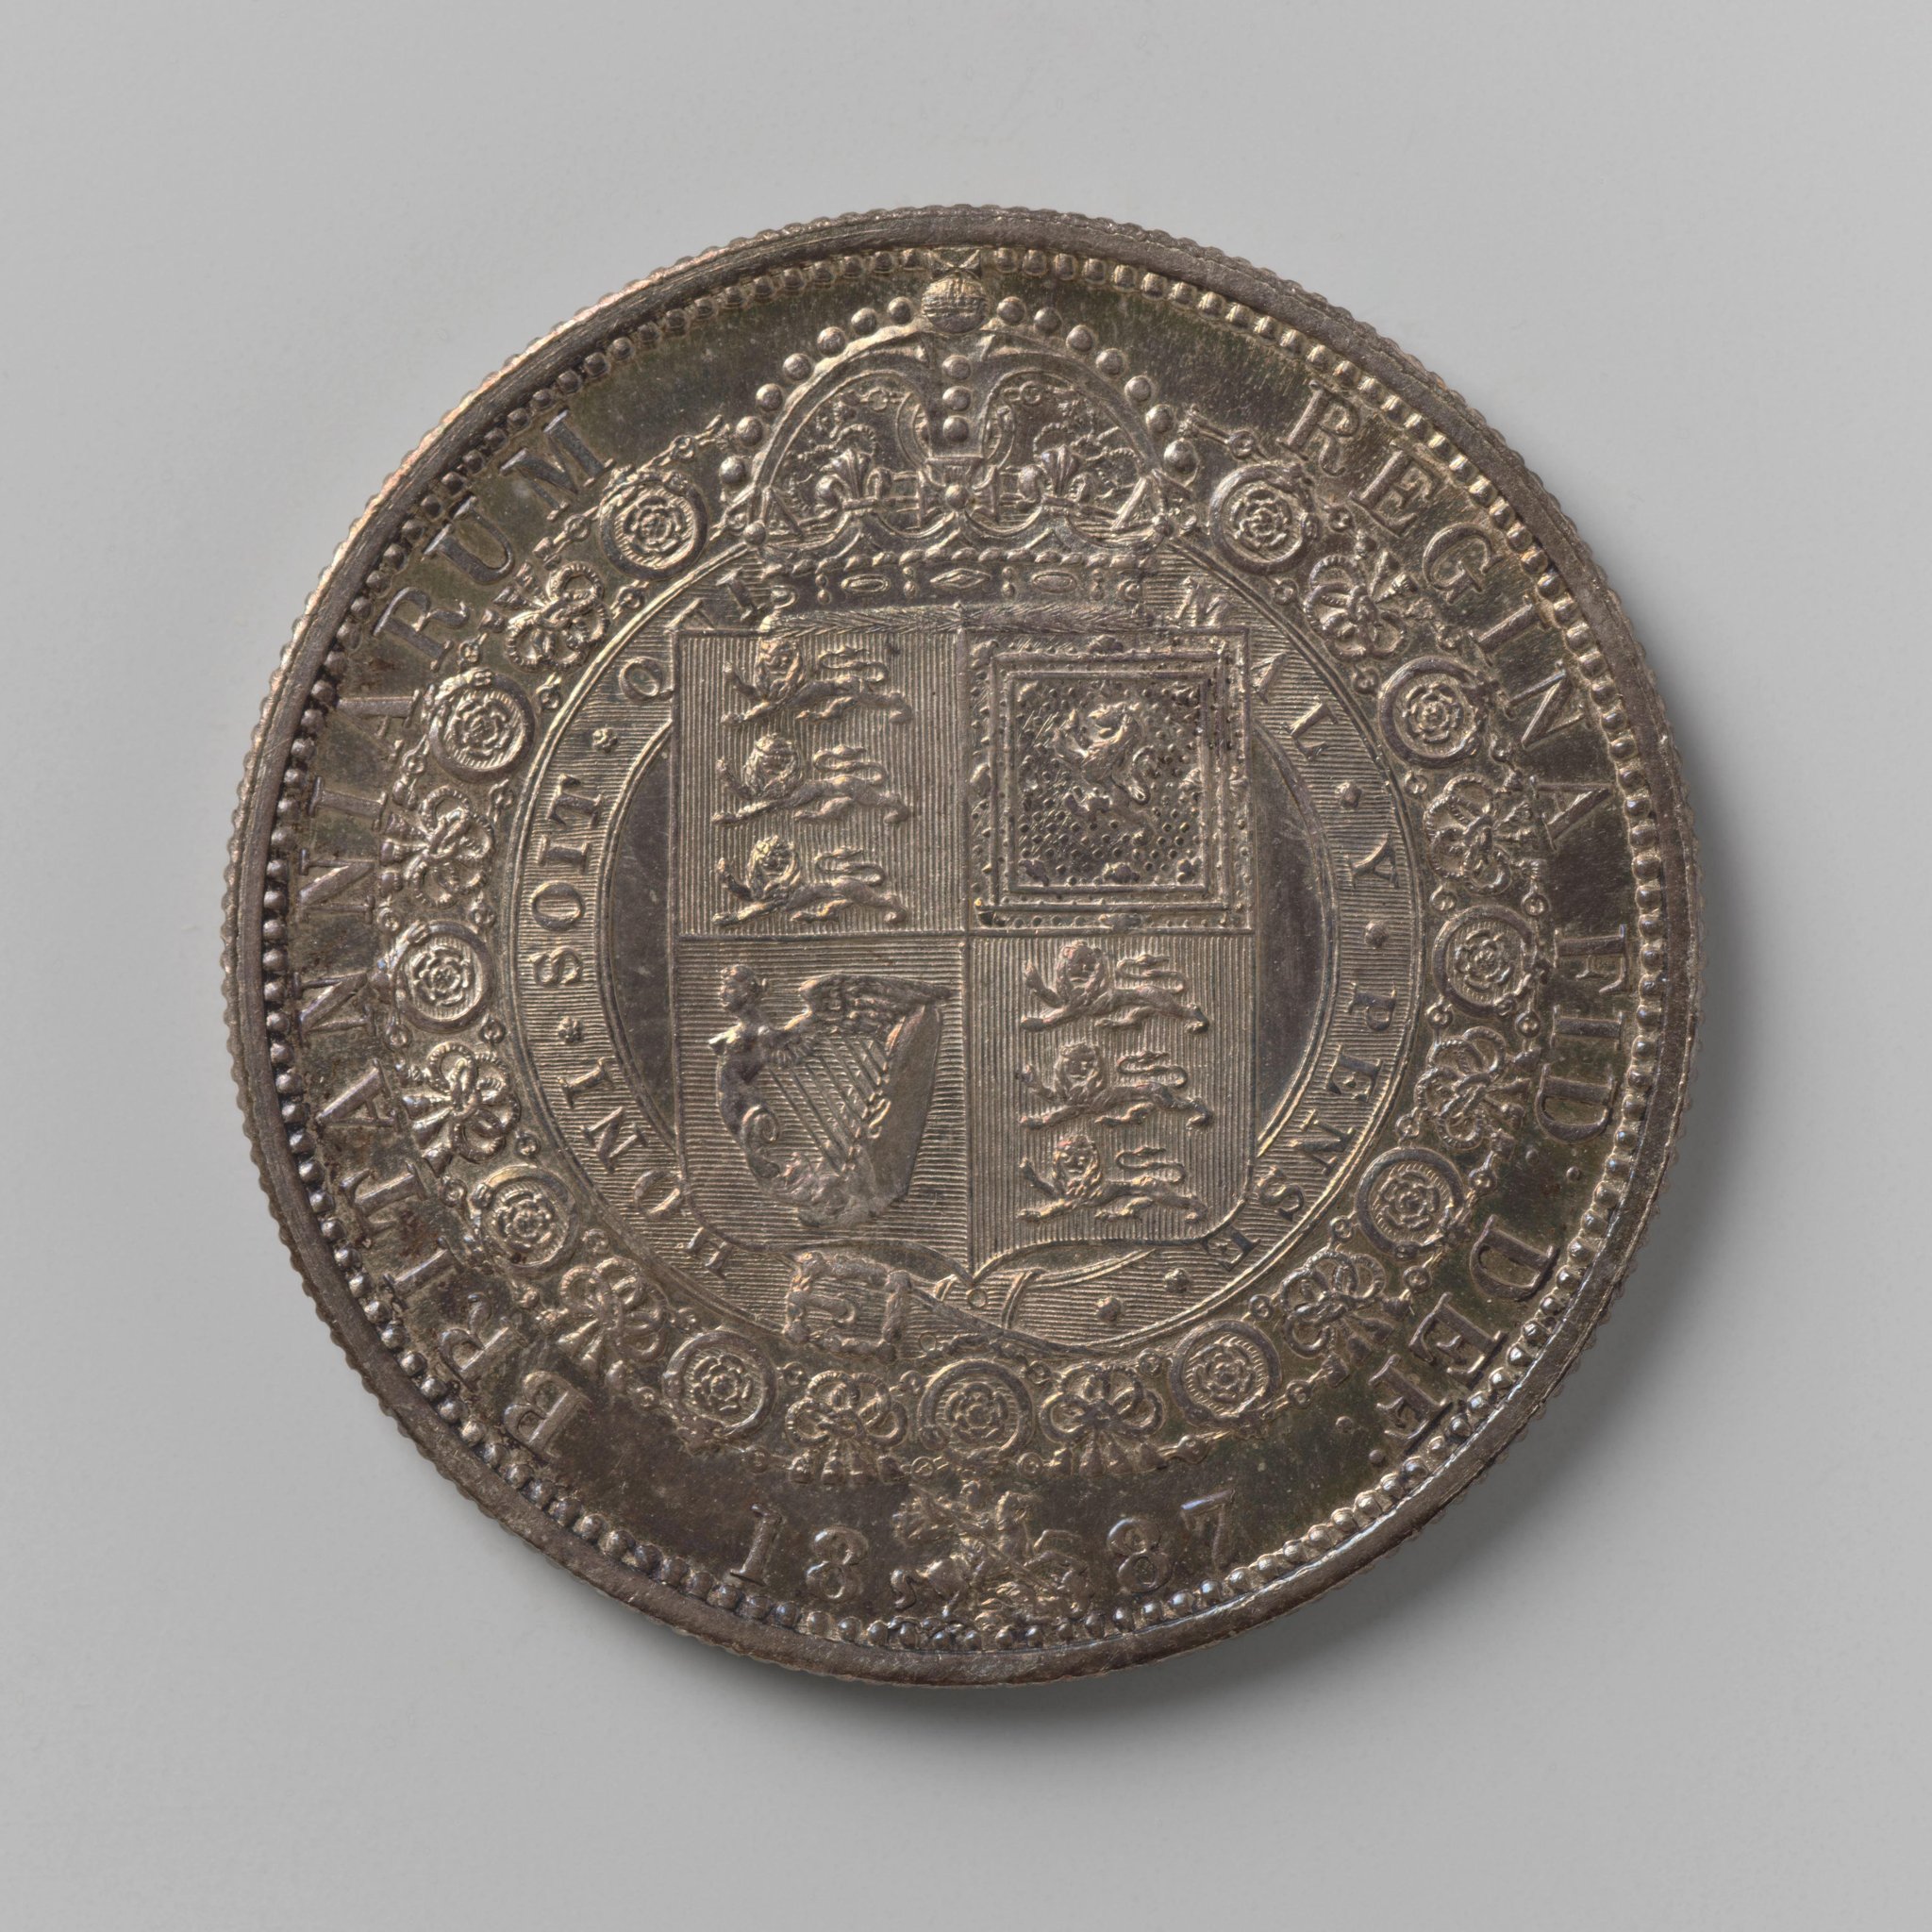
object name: coin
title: ½ crown uit Engeland van Victoria, 1887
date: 1887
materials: silver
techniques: striking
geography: london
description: Zilveren munt. Voorzijde: gekroond hoofd van de koningin naar links [jubilee coinage]. Keerzijde: omhangen door de tekenen van de orde van Sint Joris en van de kousenband gekroond samengesteld wapenschild. Jaartal onderaan. Kartelrand.